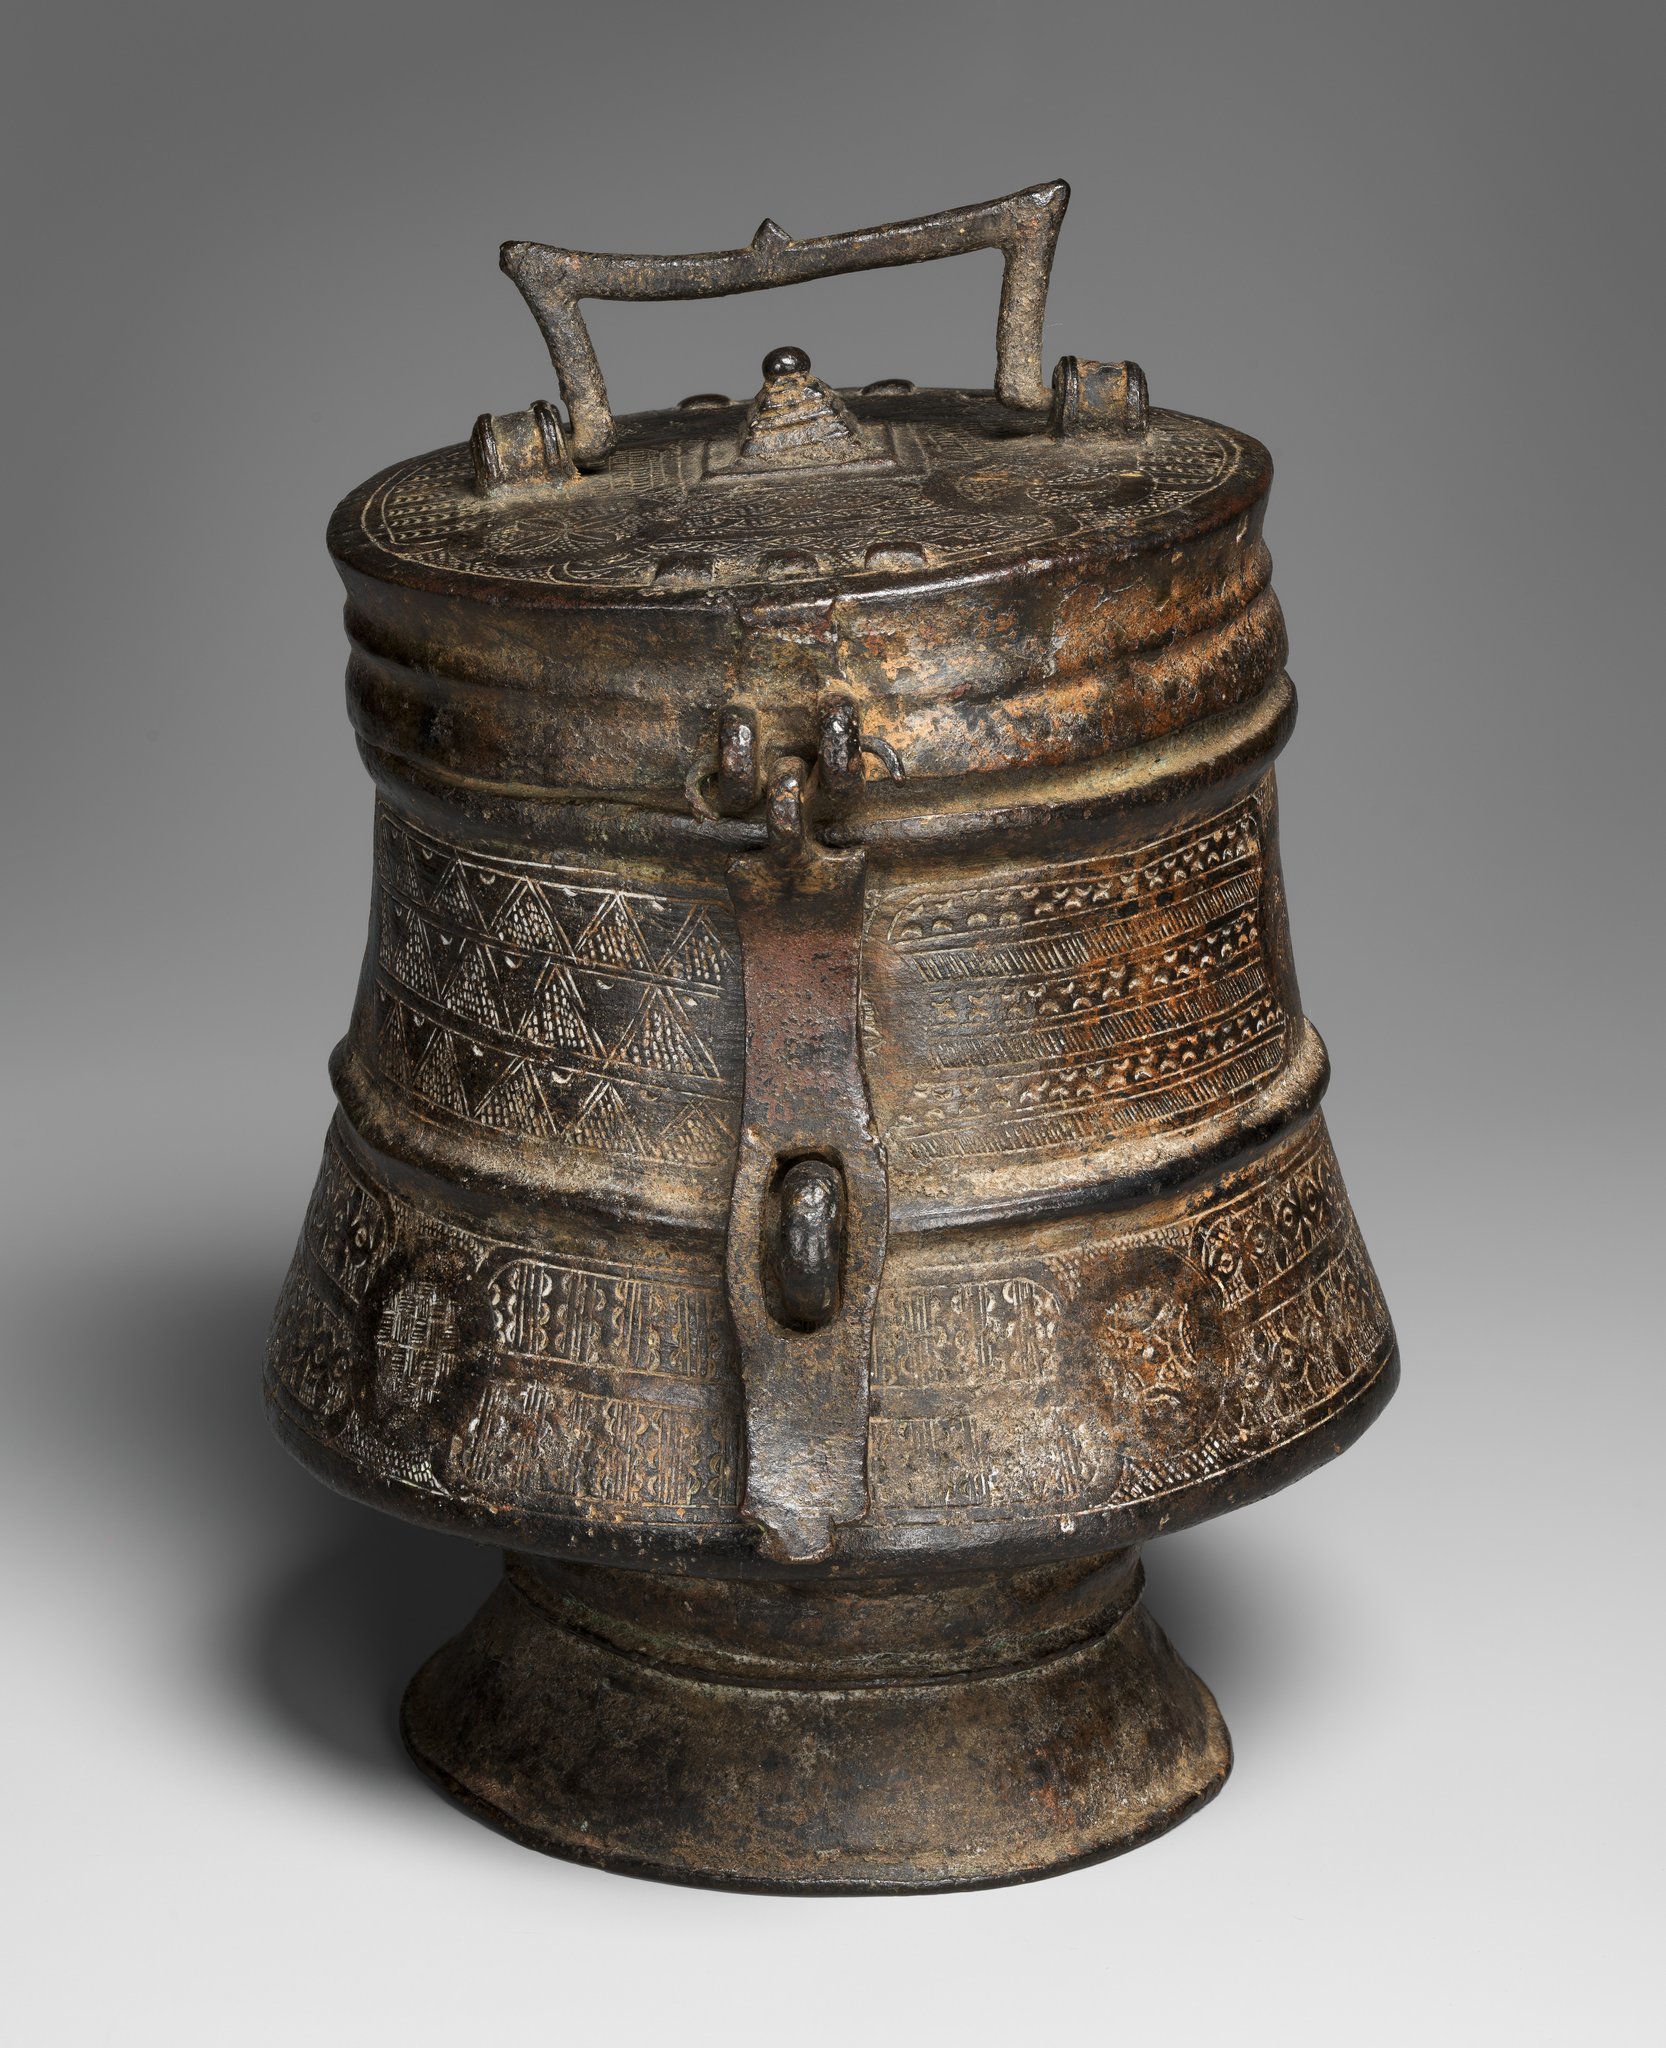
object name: vessel with lid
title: Kuduo vessel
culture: akan peoples, asante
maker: asante-akan artist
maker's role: artist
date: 1701-1900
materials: brass, pigment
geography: ghana